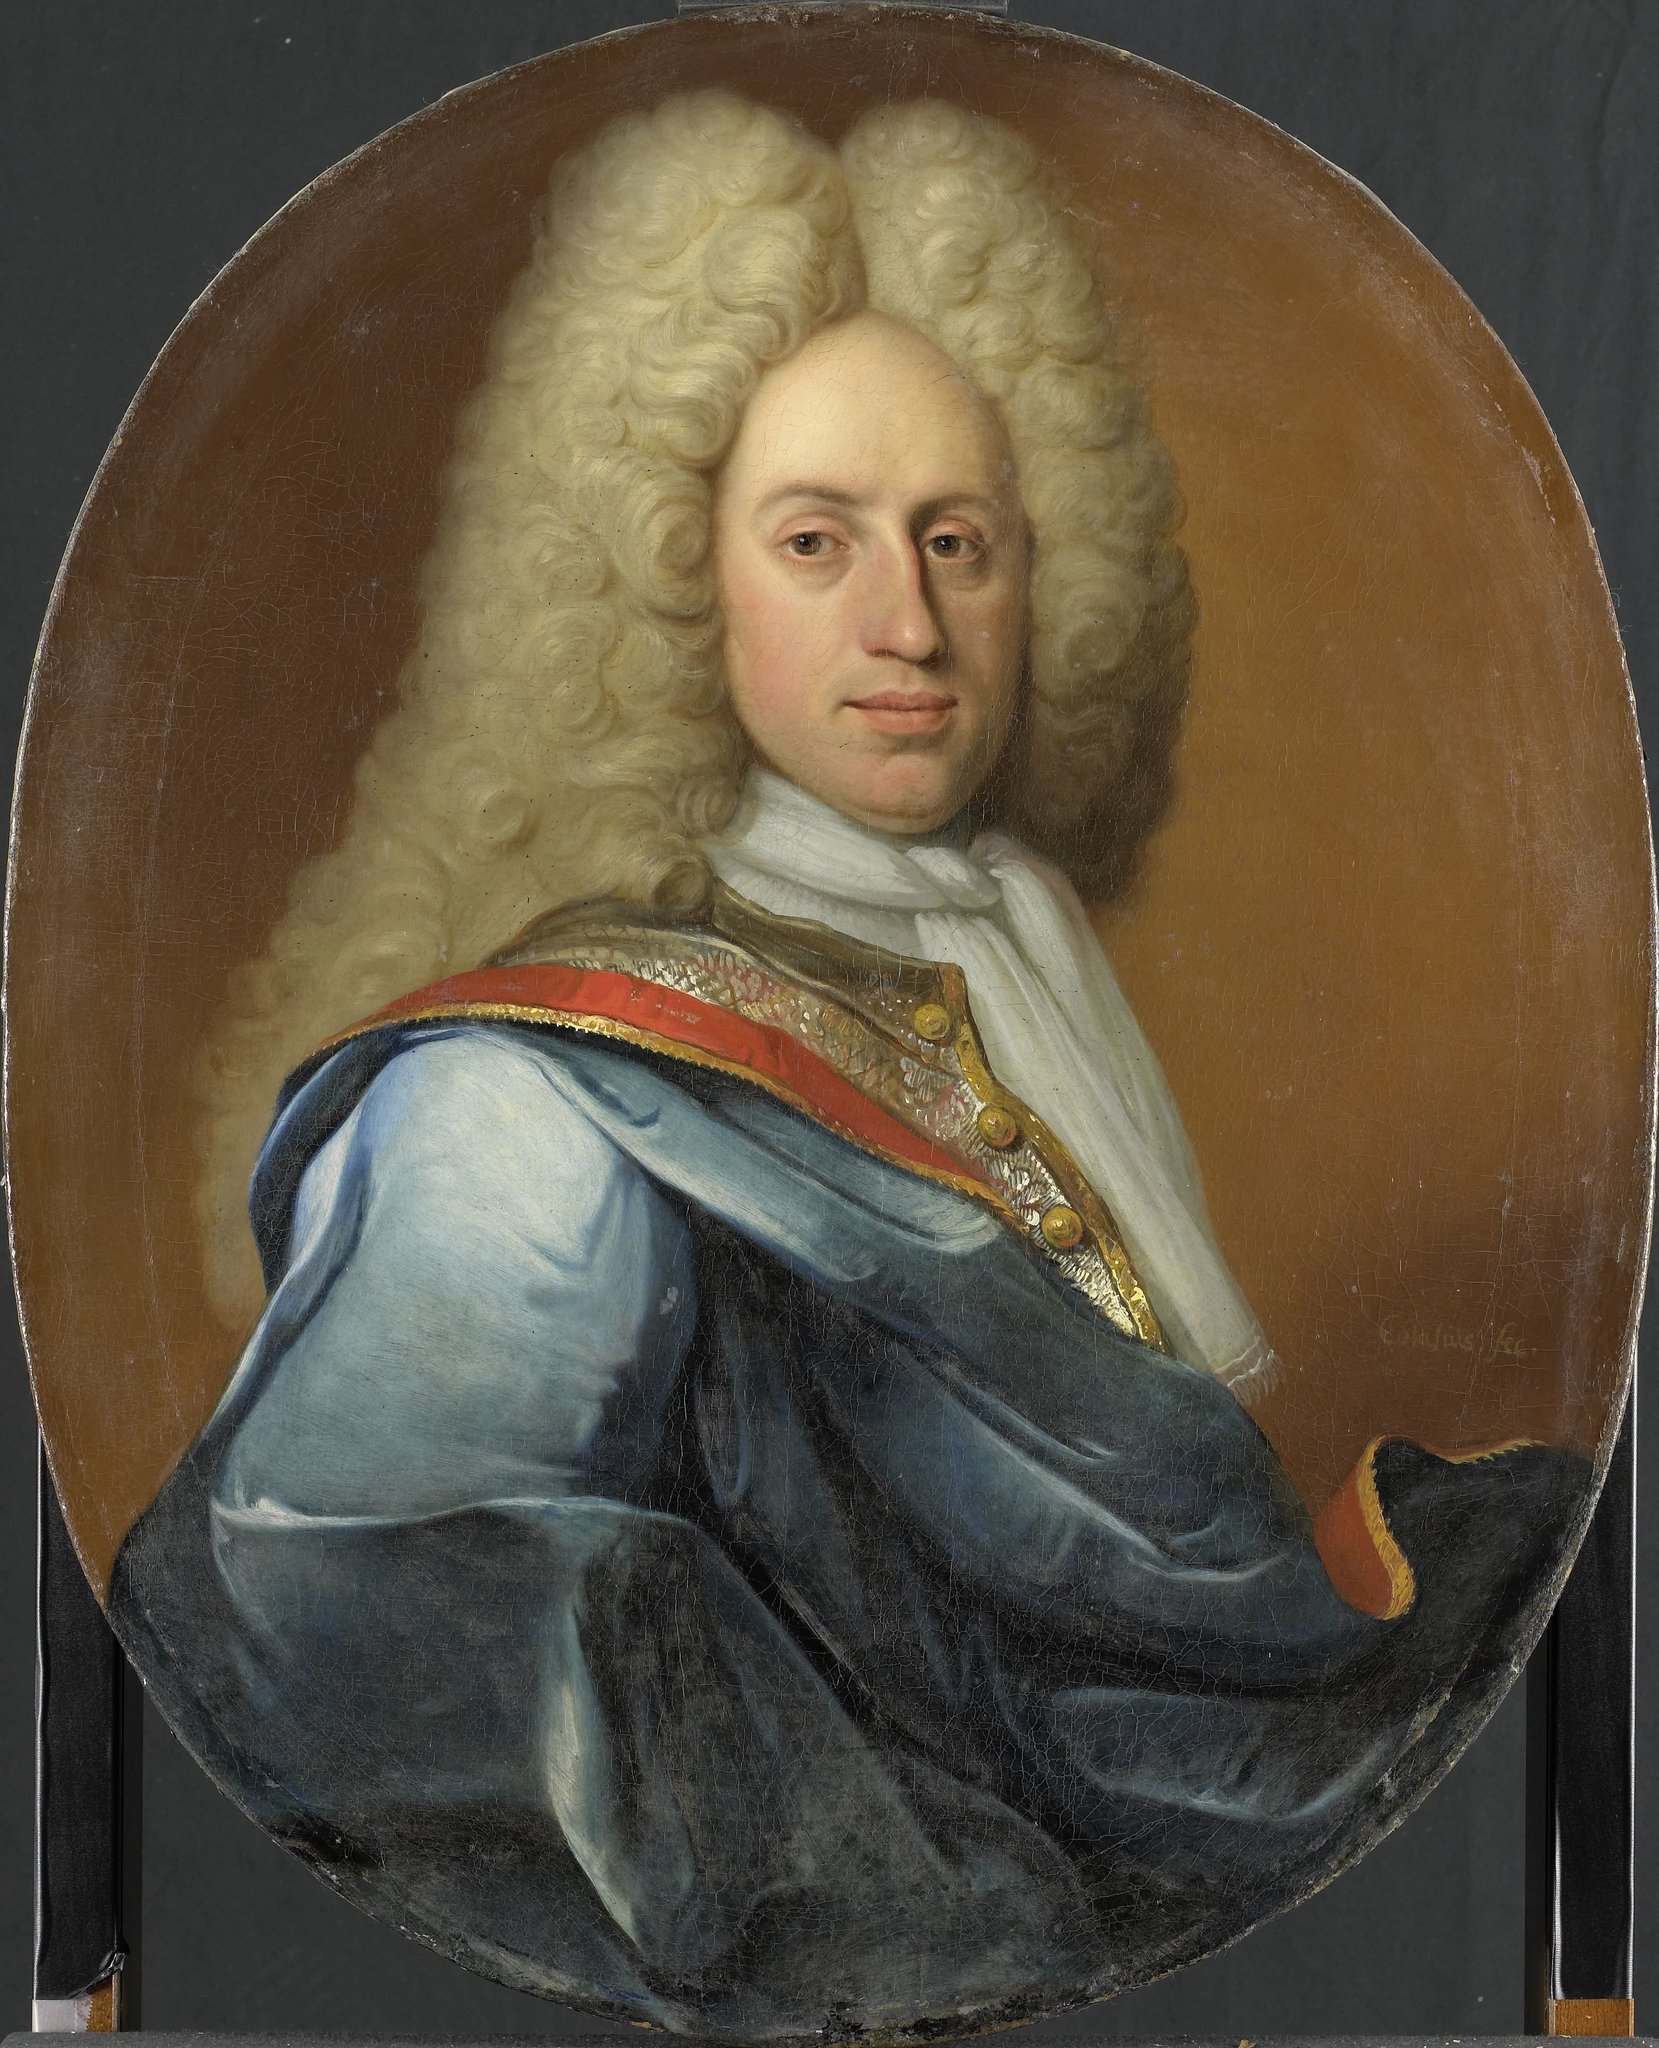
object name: painting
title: Hieronymus Josephus Boudaen, Lord of St Laurens and Popkensburg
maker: johan george collasius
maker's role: draughtsman, painter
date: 1700-1750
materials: canvas, oil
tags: historical persons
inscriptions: signature: ‘Colasius fec.’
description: Portret van Hieronymus Josephus Boudaen, heer van St Laurens en Popkensburg. Buste, met een lange witte pruik.